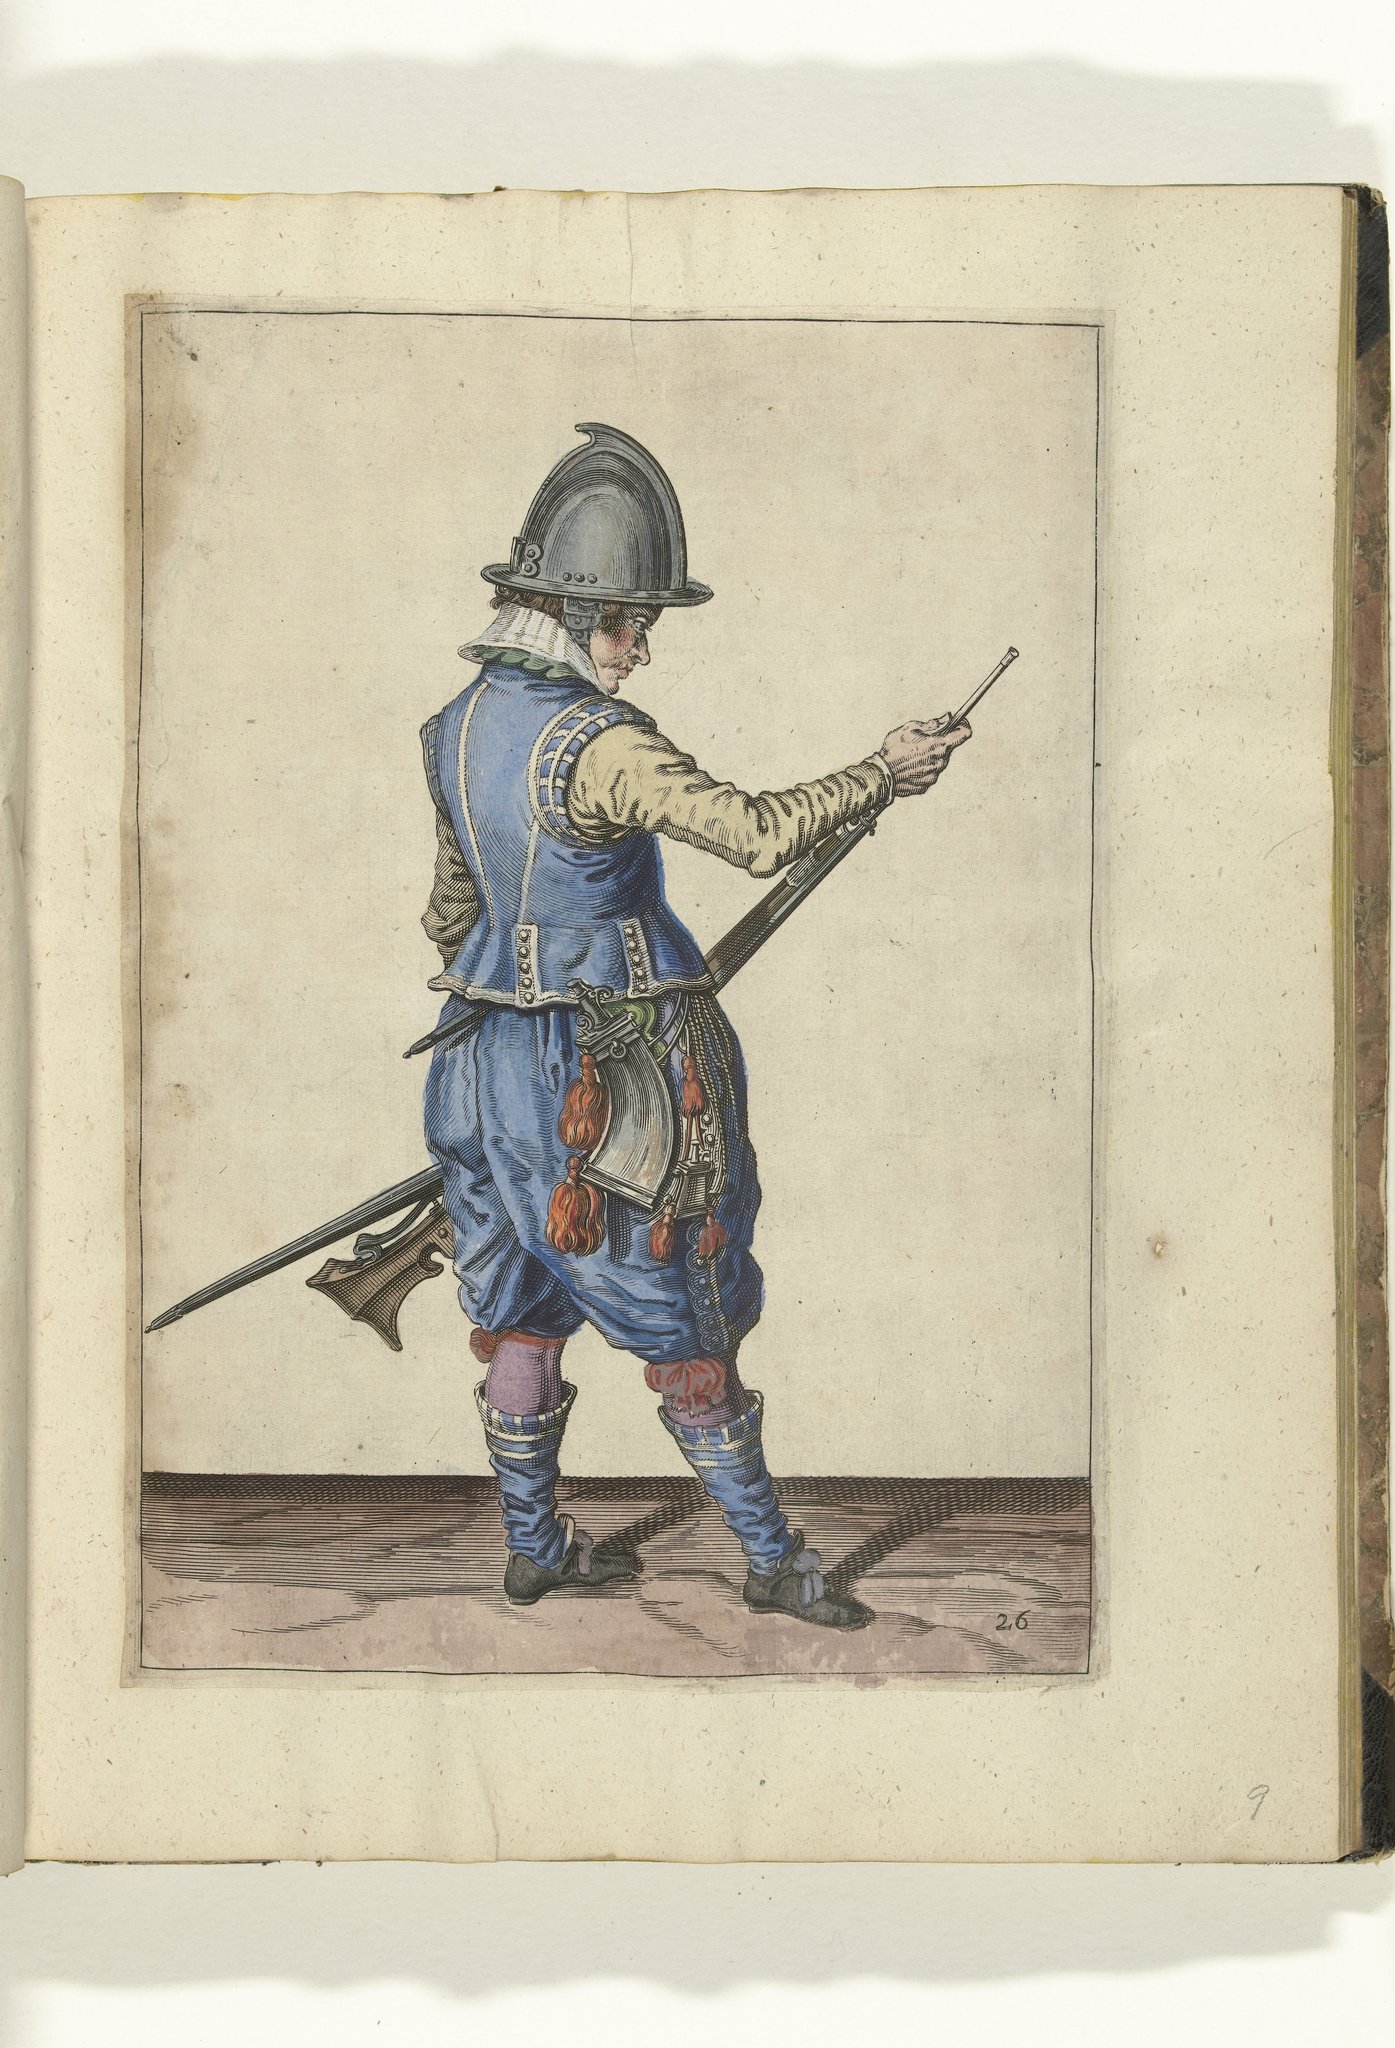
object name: print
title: Soldaat die de pan van zijn roer sluit (nr. 17), ca. 1600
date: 1597-1608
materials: paper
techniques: engraving, hand coloring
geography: northern netherlands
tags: the hague, maurice (prince of orange), handling of weapons ~ military training, weapons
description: Een soldaat, ten voeten uit, naar rechts, die met zijn rechterhand de pan (het kruitreservoir) van zijn roer (een bepaald type vuurwapen) sluit (nr. 17), ca. 1600. In zijn linkerhand behalve het roer ook een brandende lont. Plaat 17 in de instructies voor het hanteren van de roer: Shorte instruction upon the contrefaictinges, touching the right use of calivers. Onderdeel van de illustraties in een Engelse editie van J. de Gheyns Wapenhandelinghe: J. de Gheyn, The exercise of armes for calivres, muskettes and pikes after the ordre of Maurits Prince of Orange, 's-Gravenhage 1608. Krijgswezen rond 1600.